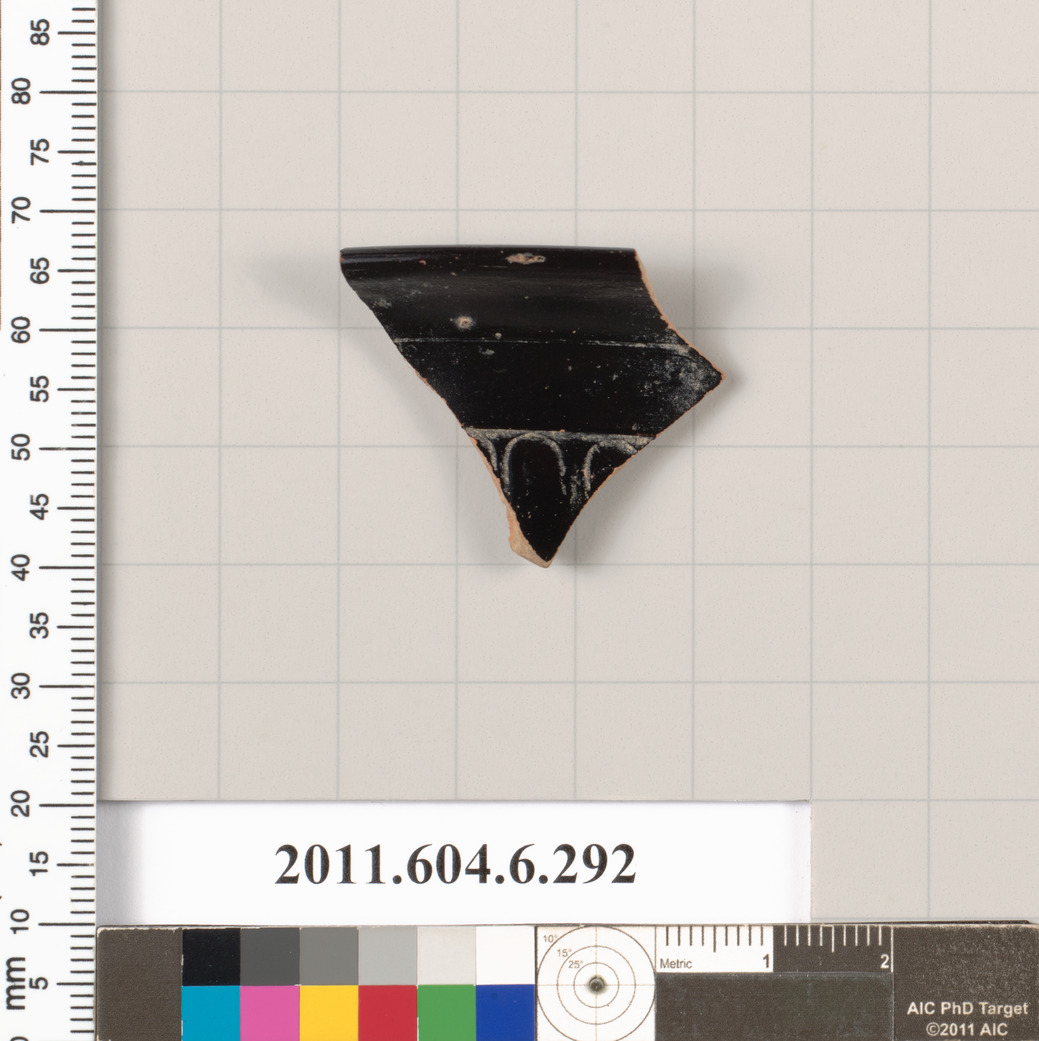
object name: calyx cup fragment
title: Terracotta fragment of a calyx-cup?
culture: greek, attic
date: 367-335 BCE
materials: terracotta